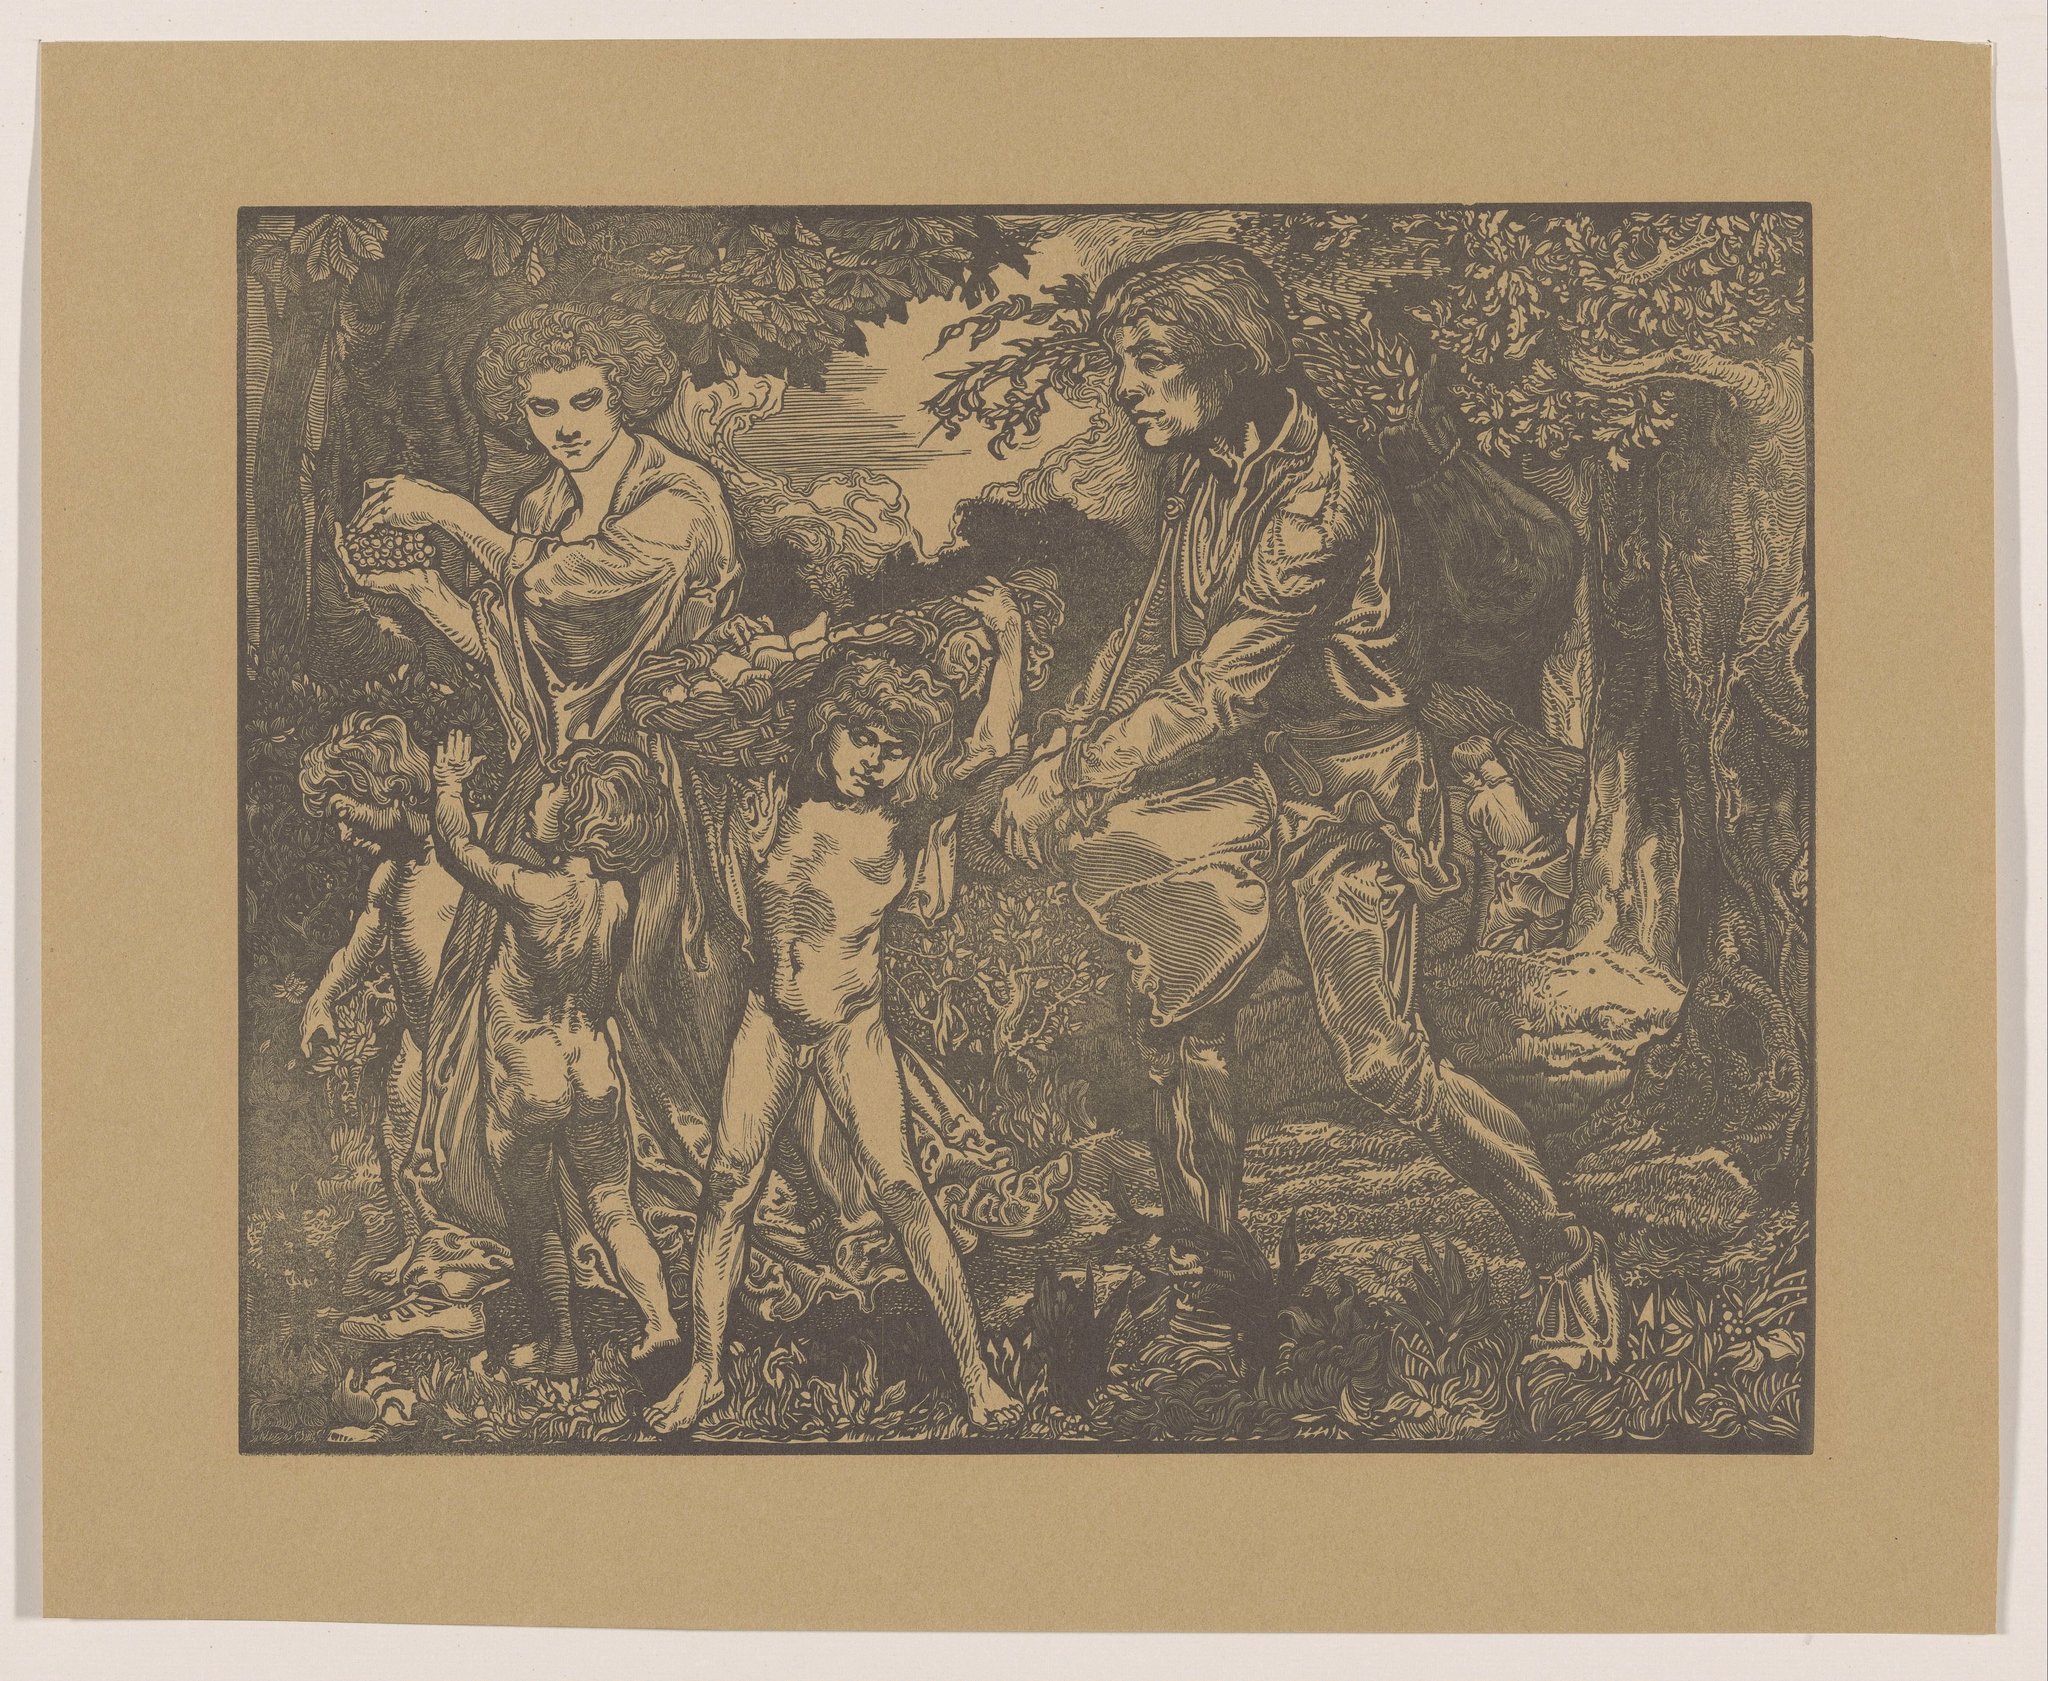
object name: print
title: Fruitoogst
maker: johannes josephus aarts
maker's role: draughtsman, print maker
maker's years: 1871-1934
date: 1908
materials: paper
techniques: woodcut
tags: fruit harvest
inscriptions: collector's mark: Lugt 2166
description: Een man en een vrouw in een met bomen begroeid landschap. Om hen heen drie naakte kinderen, waarvan er één een mand met fruit op zijn schouders draagt. De vrouw houdt een druiventros in haar handen. Op de achtergrond draagt een man een bos takken op zijn rug.